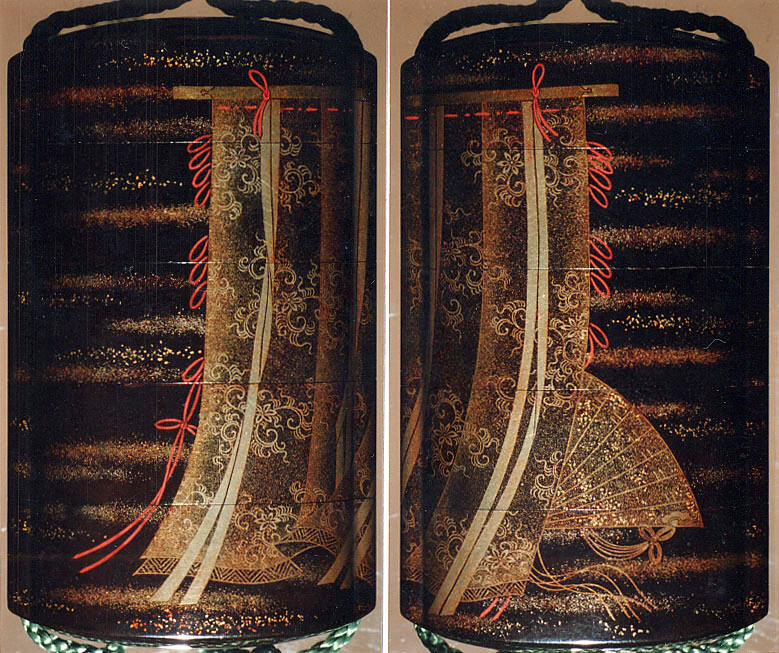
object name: inrō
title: Case (Inrō) with Design of Curtains of State and a Woman's Fan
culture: japanese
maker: koma kōryū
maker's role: artist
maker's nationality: japanese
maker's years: -1796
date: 1767-1900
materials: gold, ivory, lacquer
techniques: polish, roiro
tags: fans,curtains